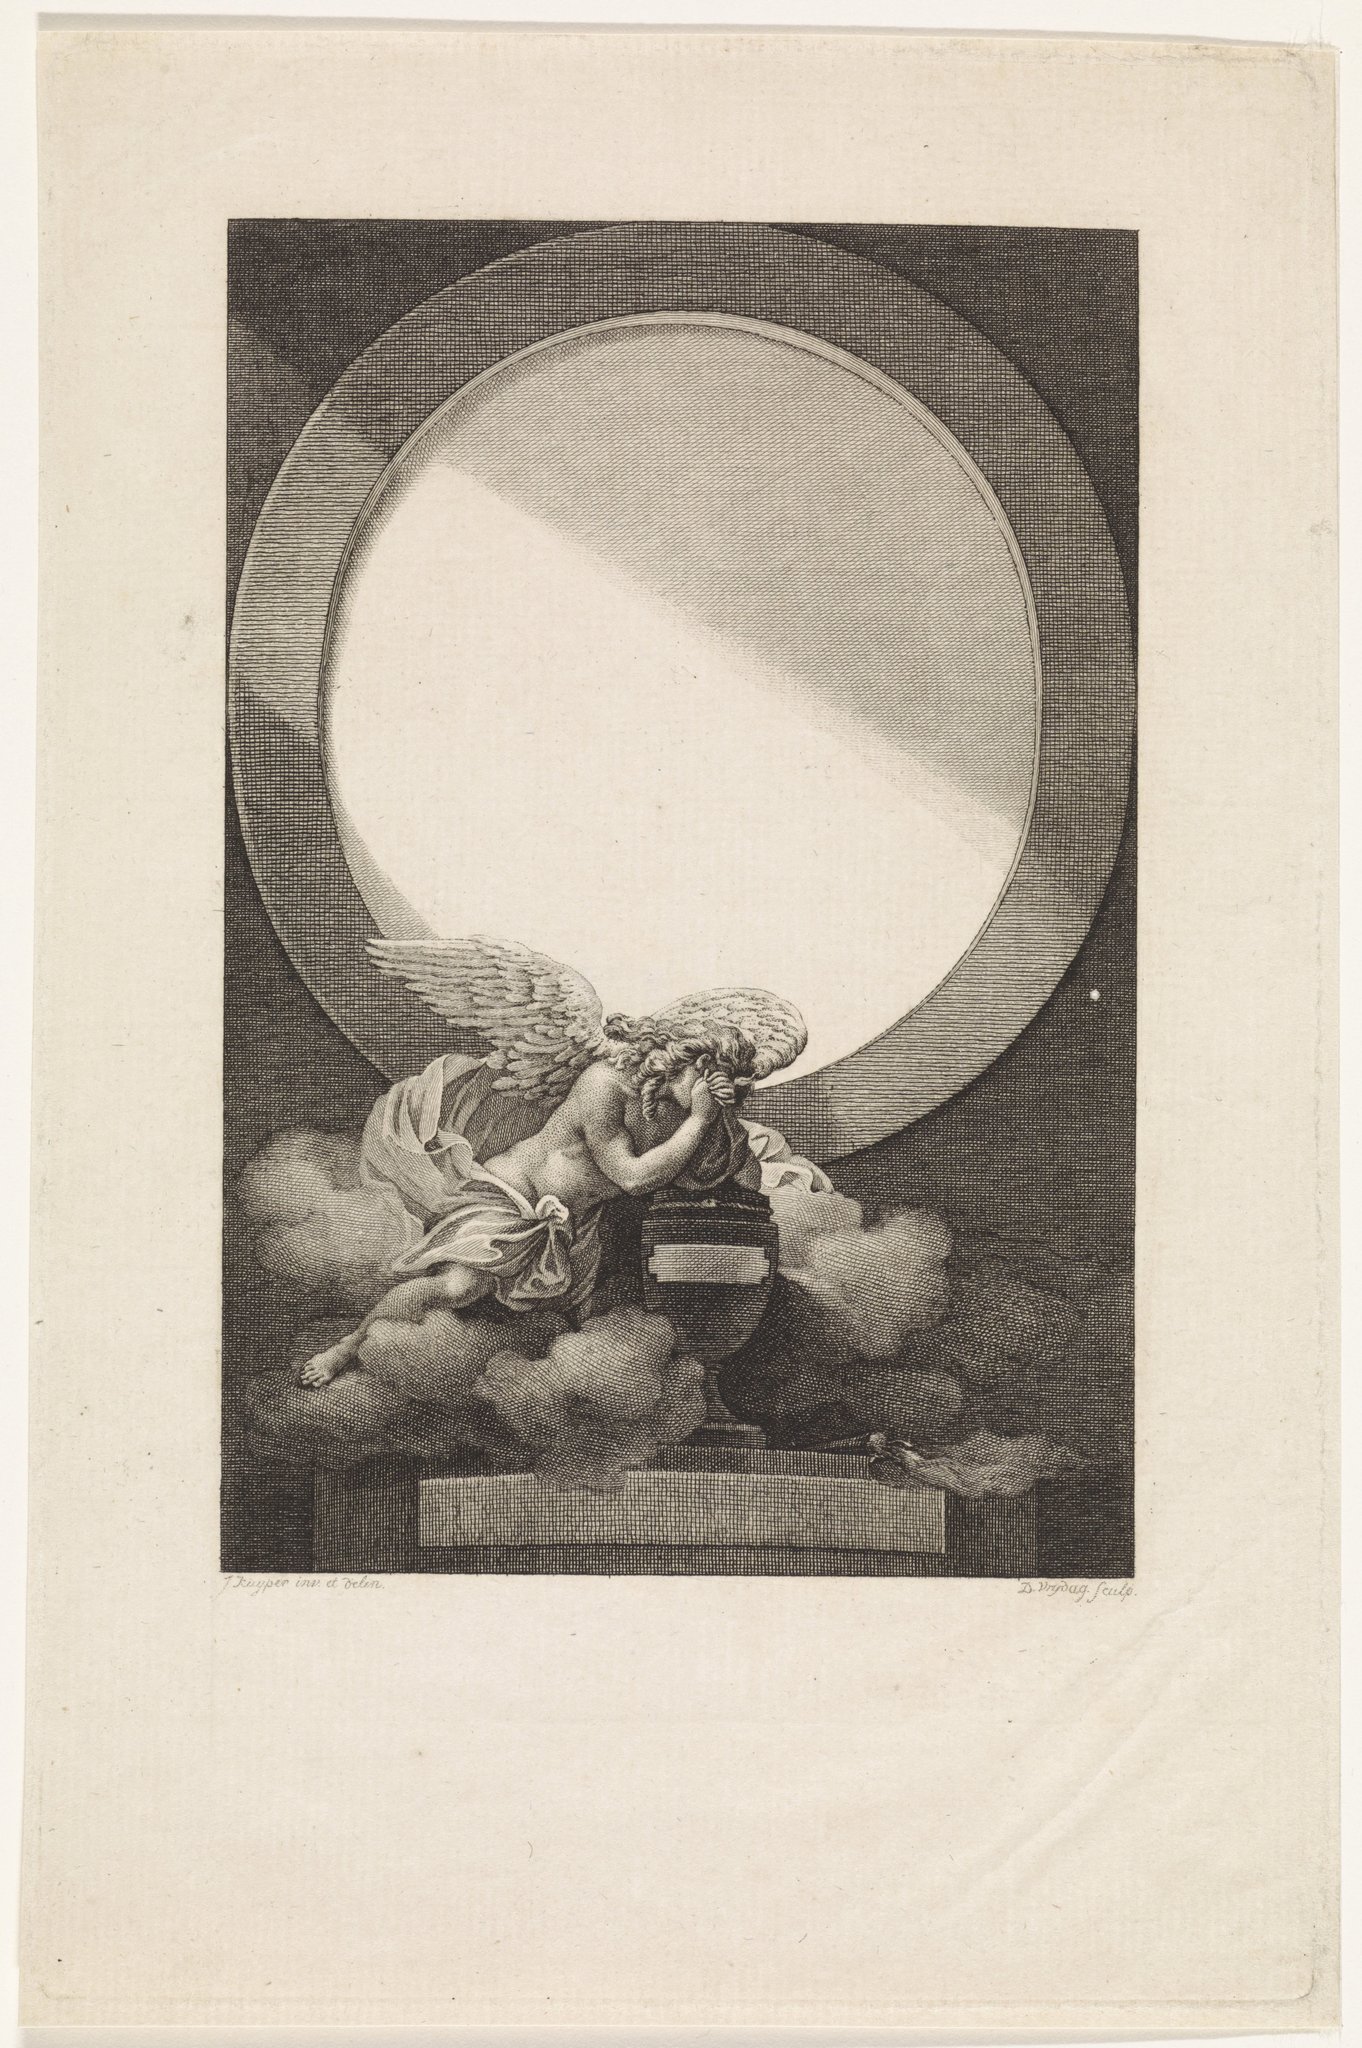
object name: print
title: Omlijsting voor een memorieprent met portret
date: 1780-1822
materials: paper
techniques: engraving, etching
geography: netherlands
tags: urn, mourning the dead, angels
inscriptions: collector's mark: Lugt 2233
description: Ovale omlijsting voor een portret. Onderaan treurt een engel bij een urn.